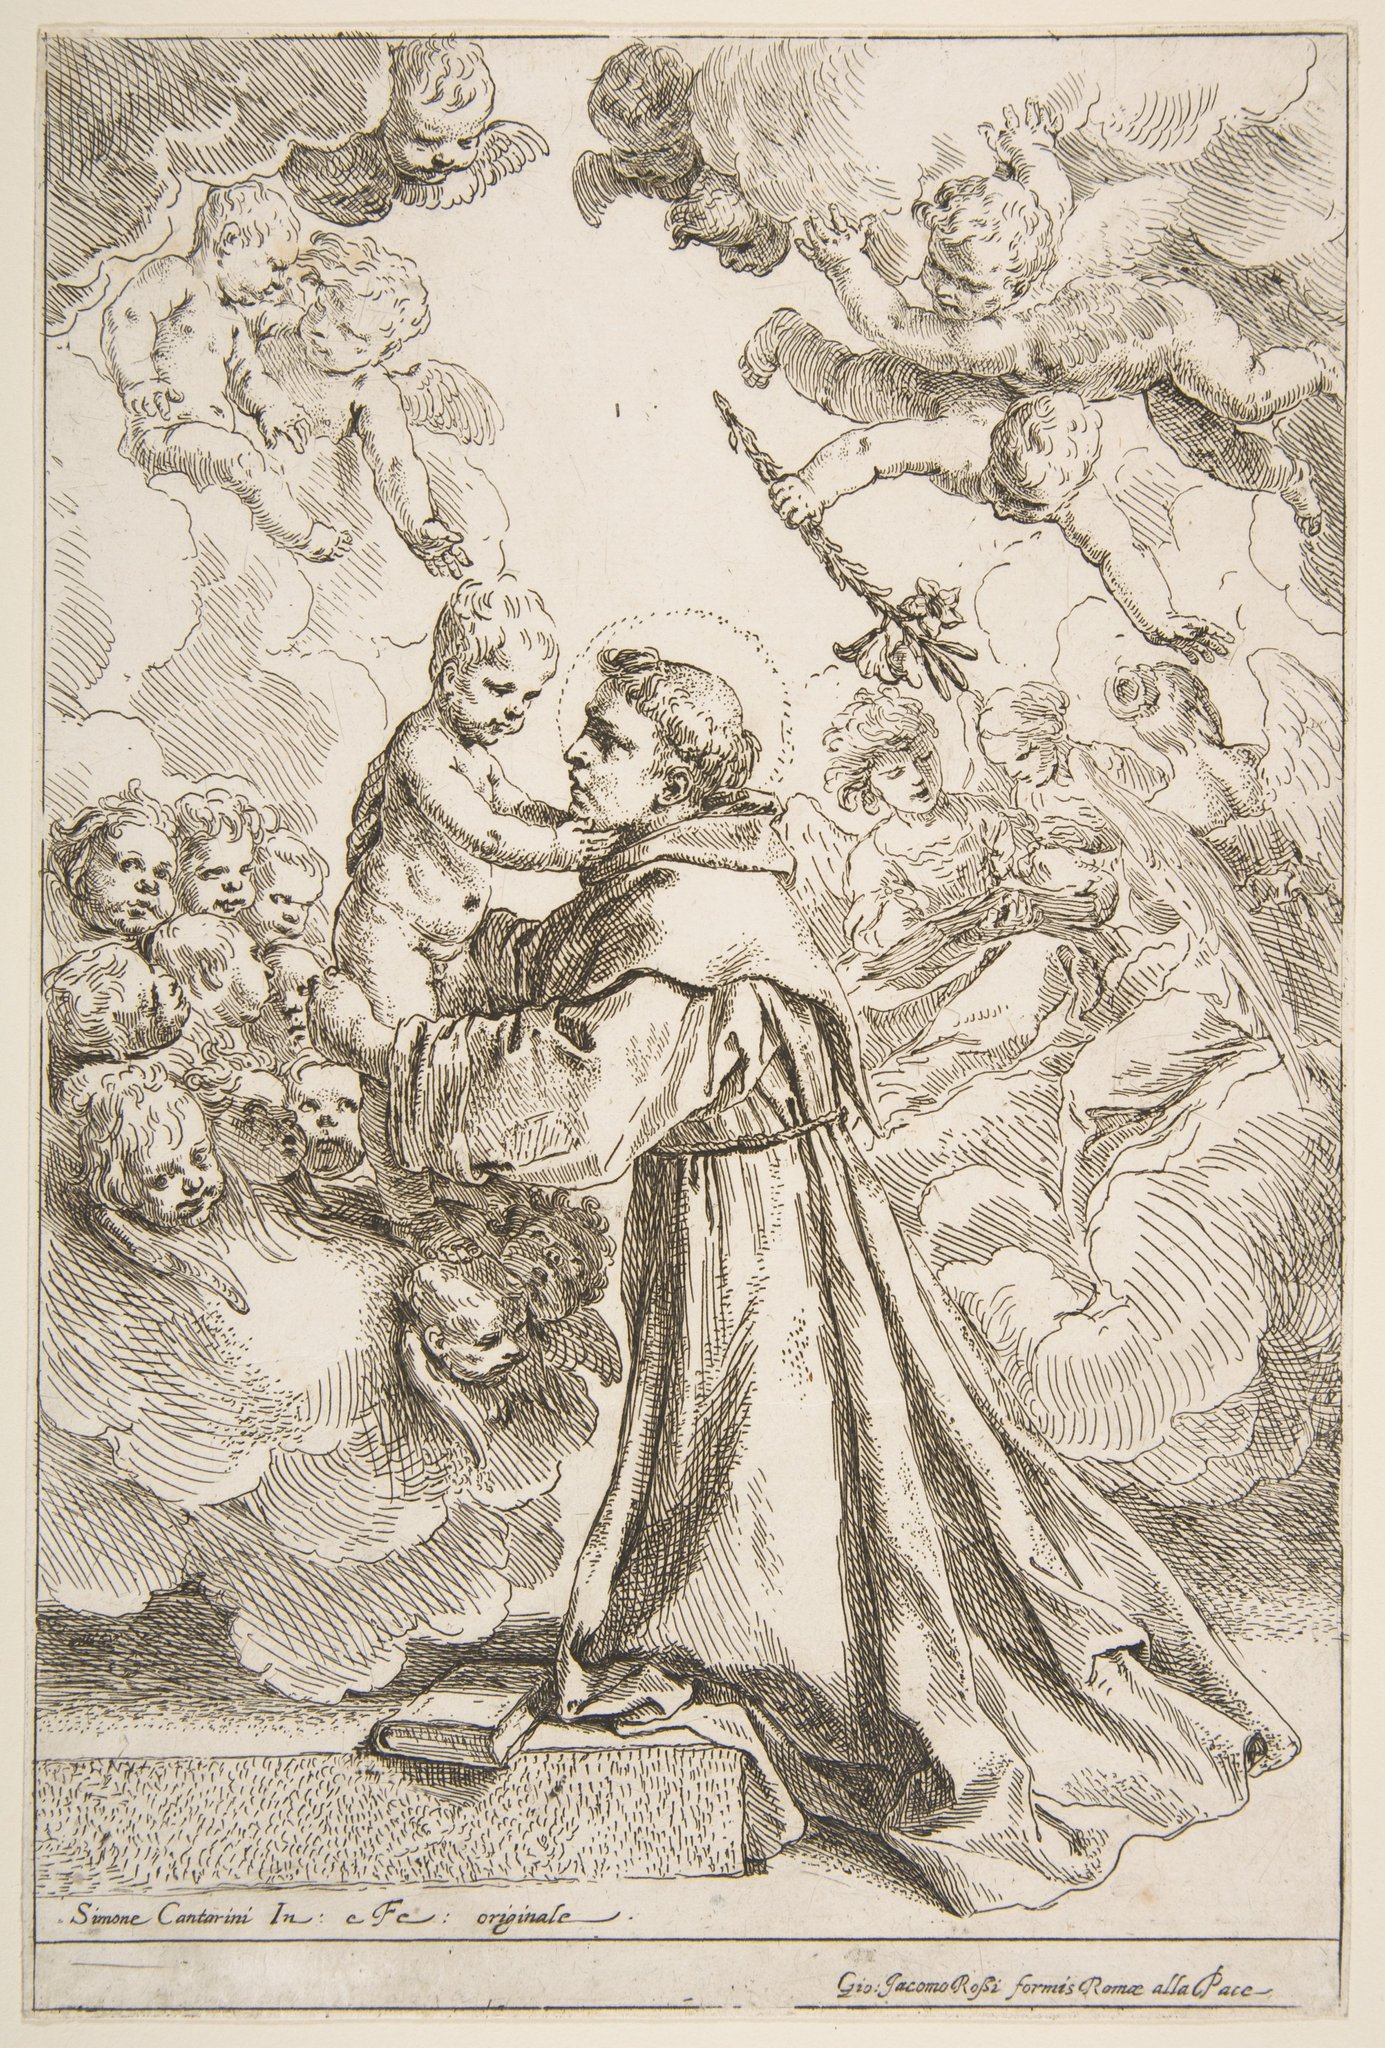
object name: print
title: Saint Anthony of Padua adoring the Christ Child in Glory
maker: simone cantarini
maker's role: artist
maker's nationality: italian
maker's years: 1612-1648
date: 1640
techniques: etching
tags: angels,christ,saint anthony